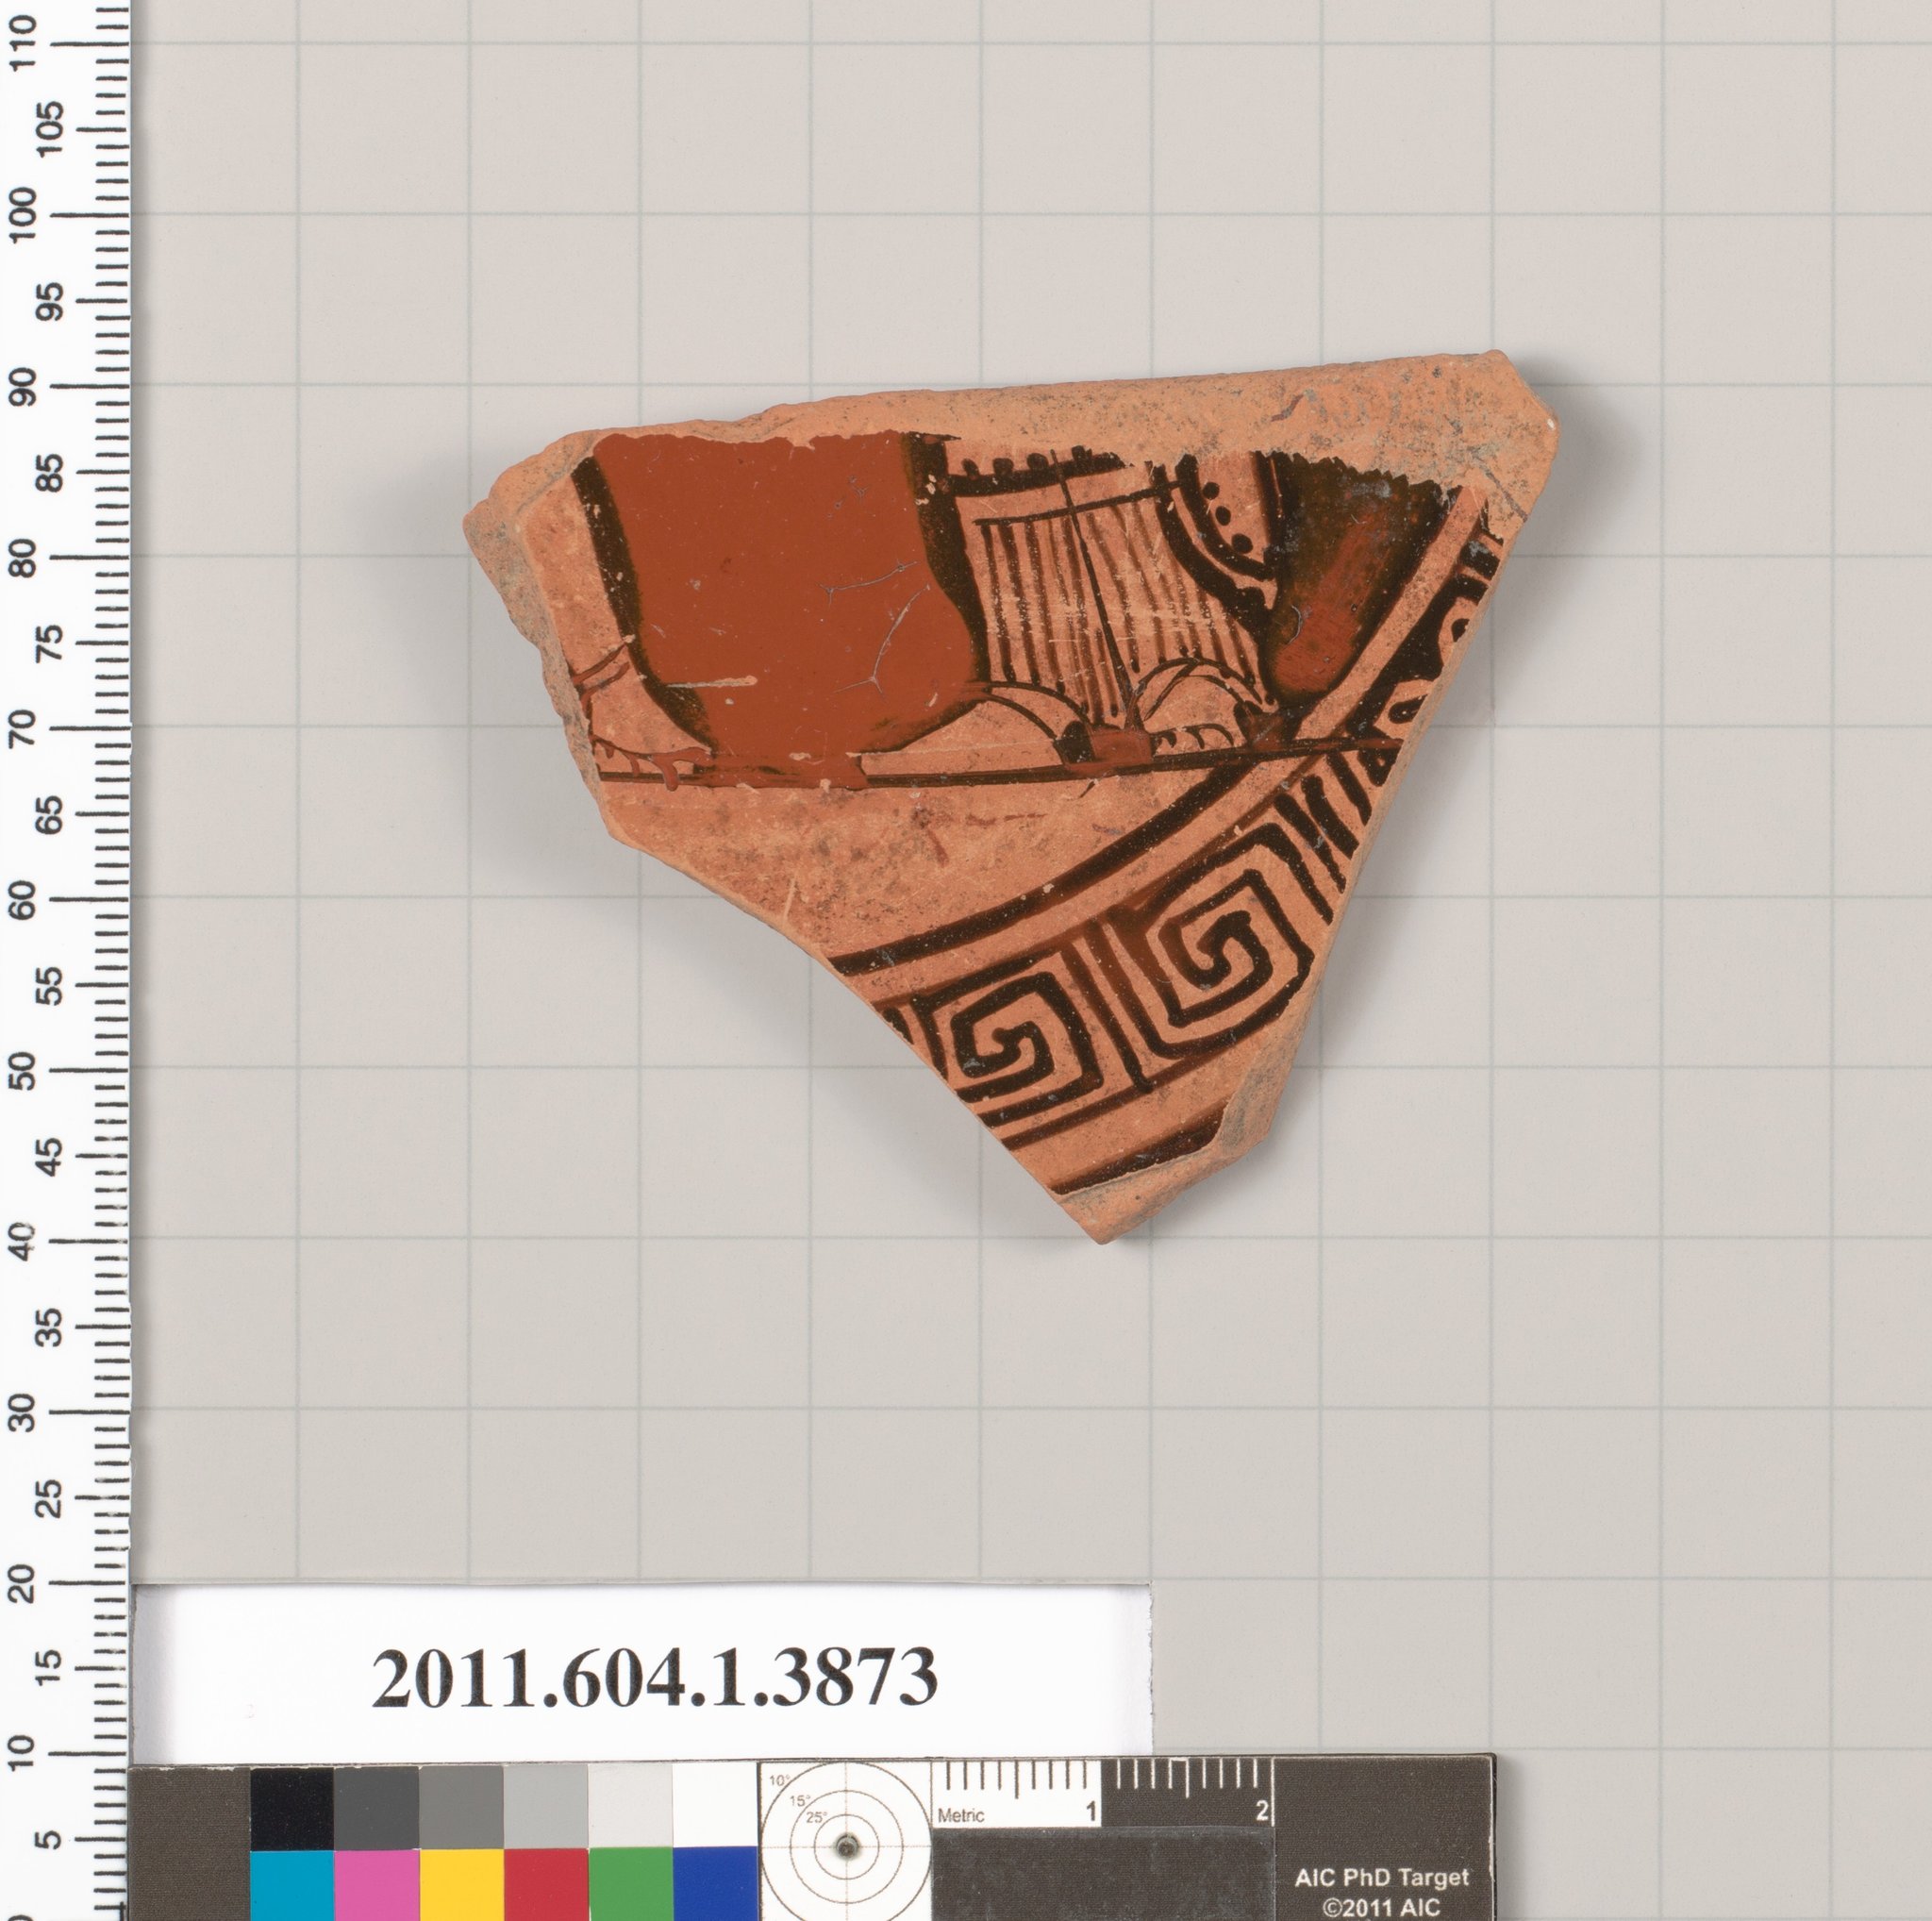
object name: kylix fragment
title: Terracotta fragment of a kylix (drinking cup)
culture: greek, attic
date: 450-426 BCE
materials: terracotta